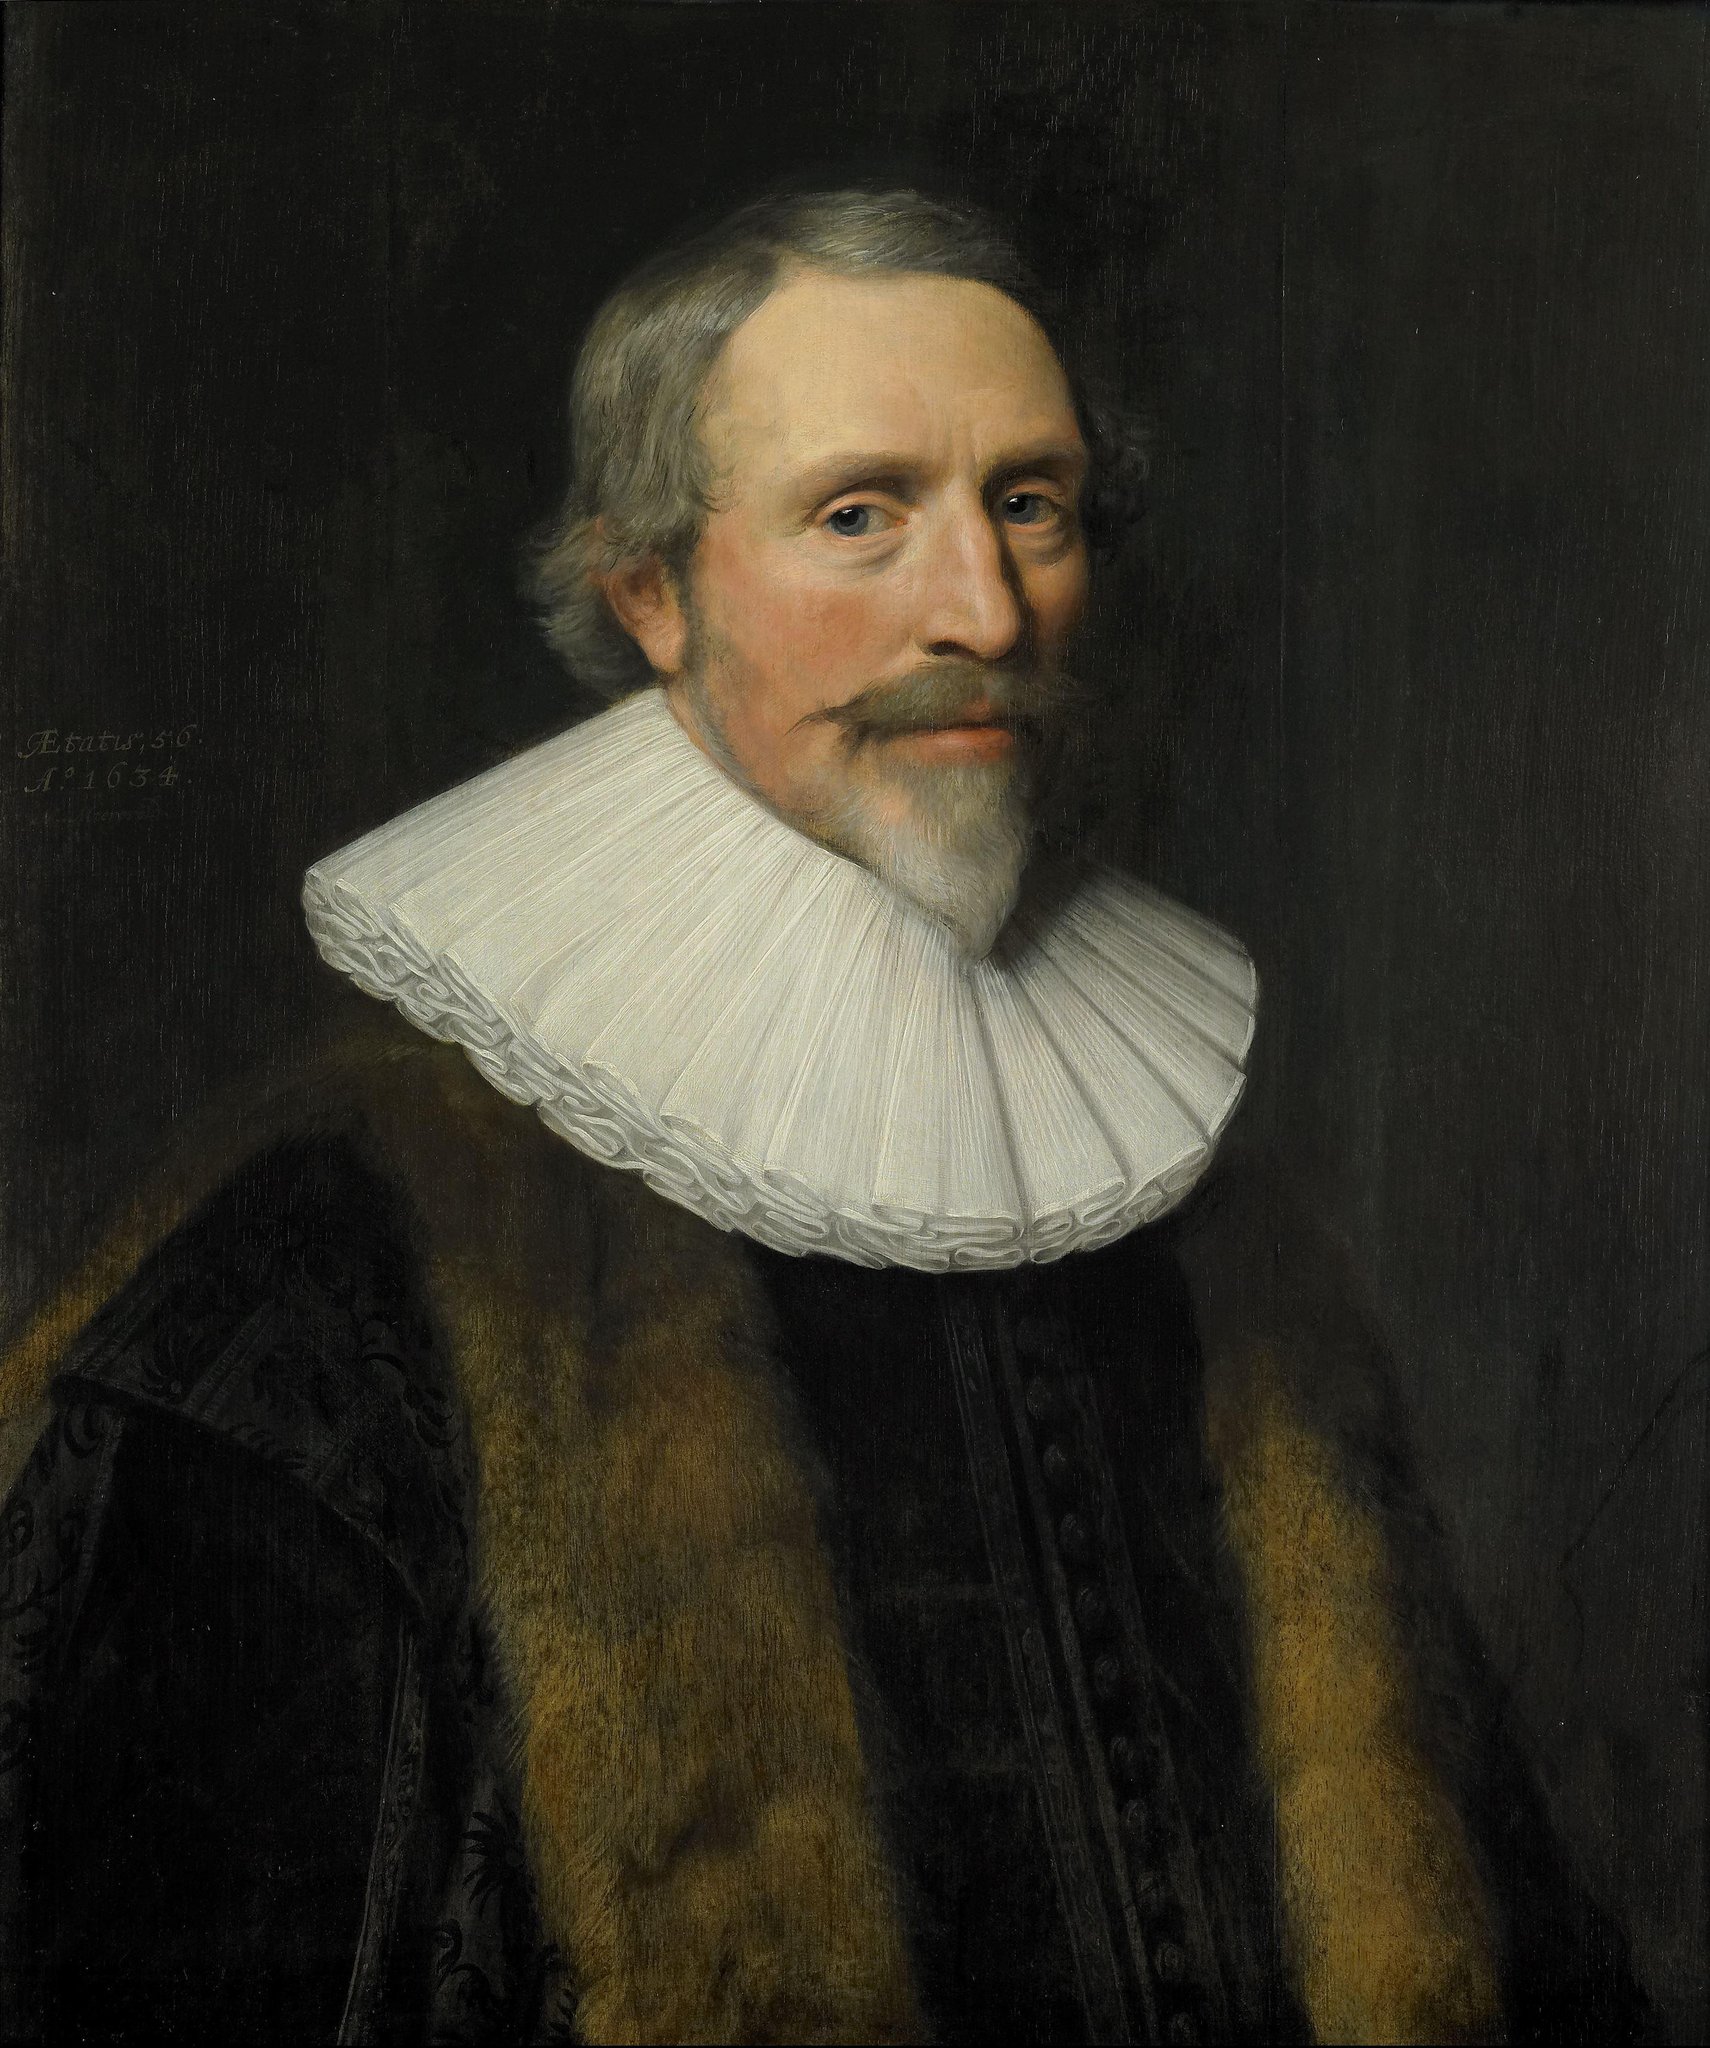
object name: painting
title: Portrait of Jacob Cats (1577-1660)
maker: michiel jansz van mierevelt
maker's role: draughtsman, painter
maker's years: 1567-1641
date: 1634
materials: oil, panel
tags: jacob cats (1577-1660), historical persons, netherlands, dordrecht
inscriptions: signature and date, centre left: ‘Ætatis, 56. / A.º 1634. / M. Miereveld’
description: Portret van Jacob Cats, pensionaris van Dordrecht en dichter. Buste, naar rechts.